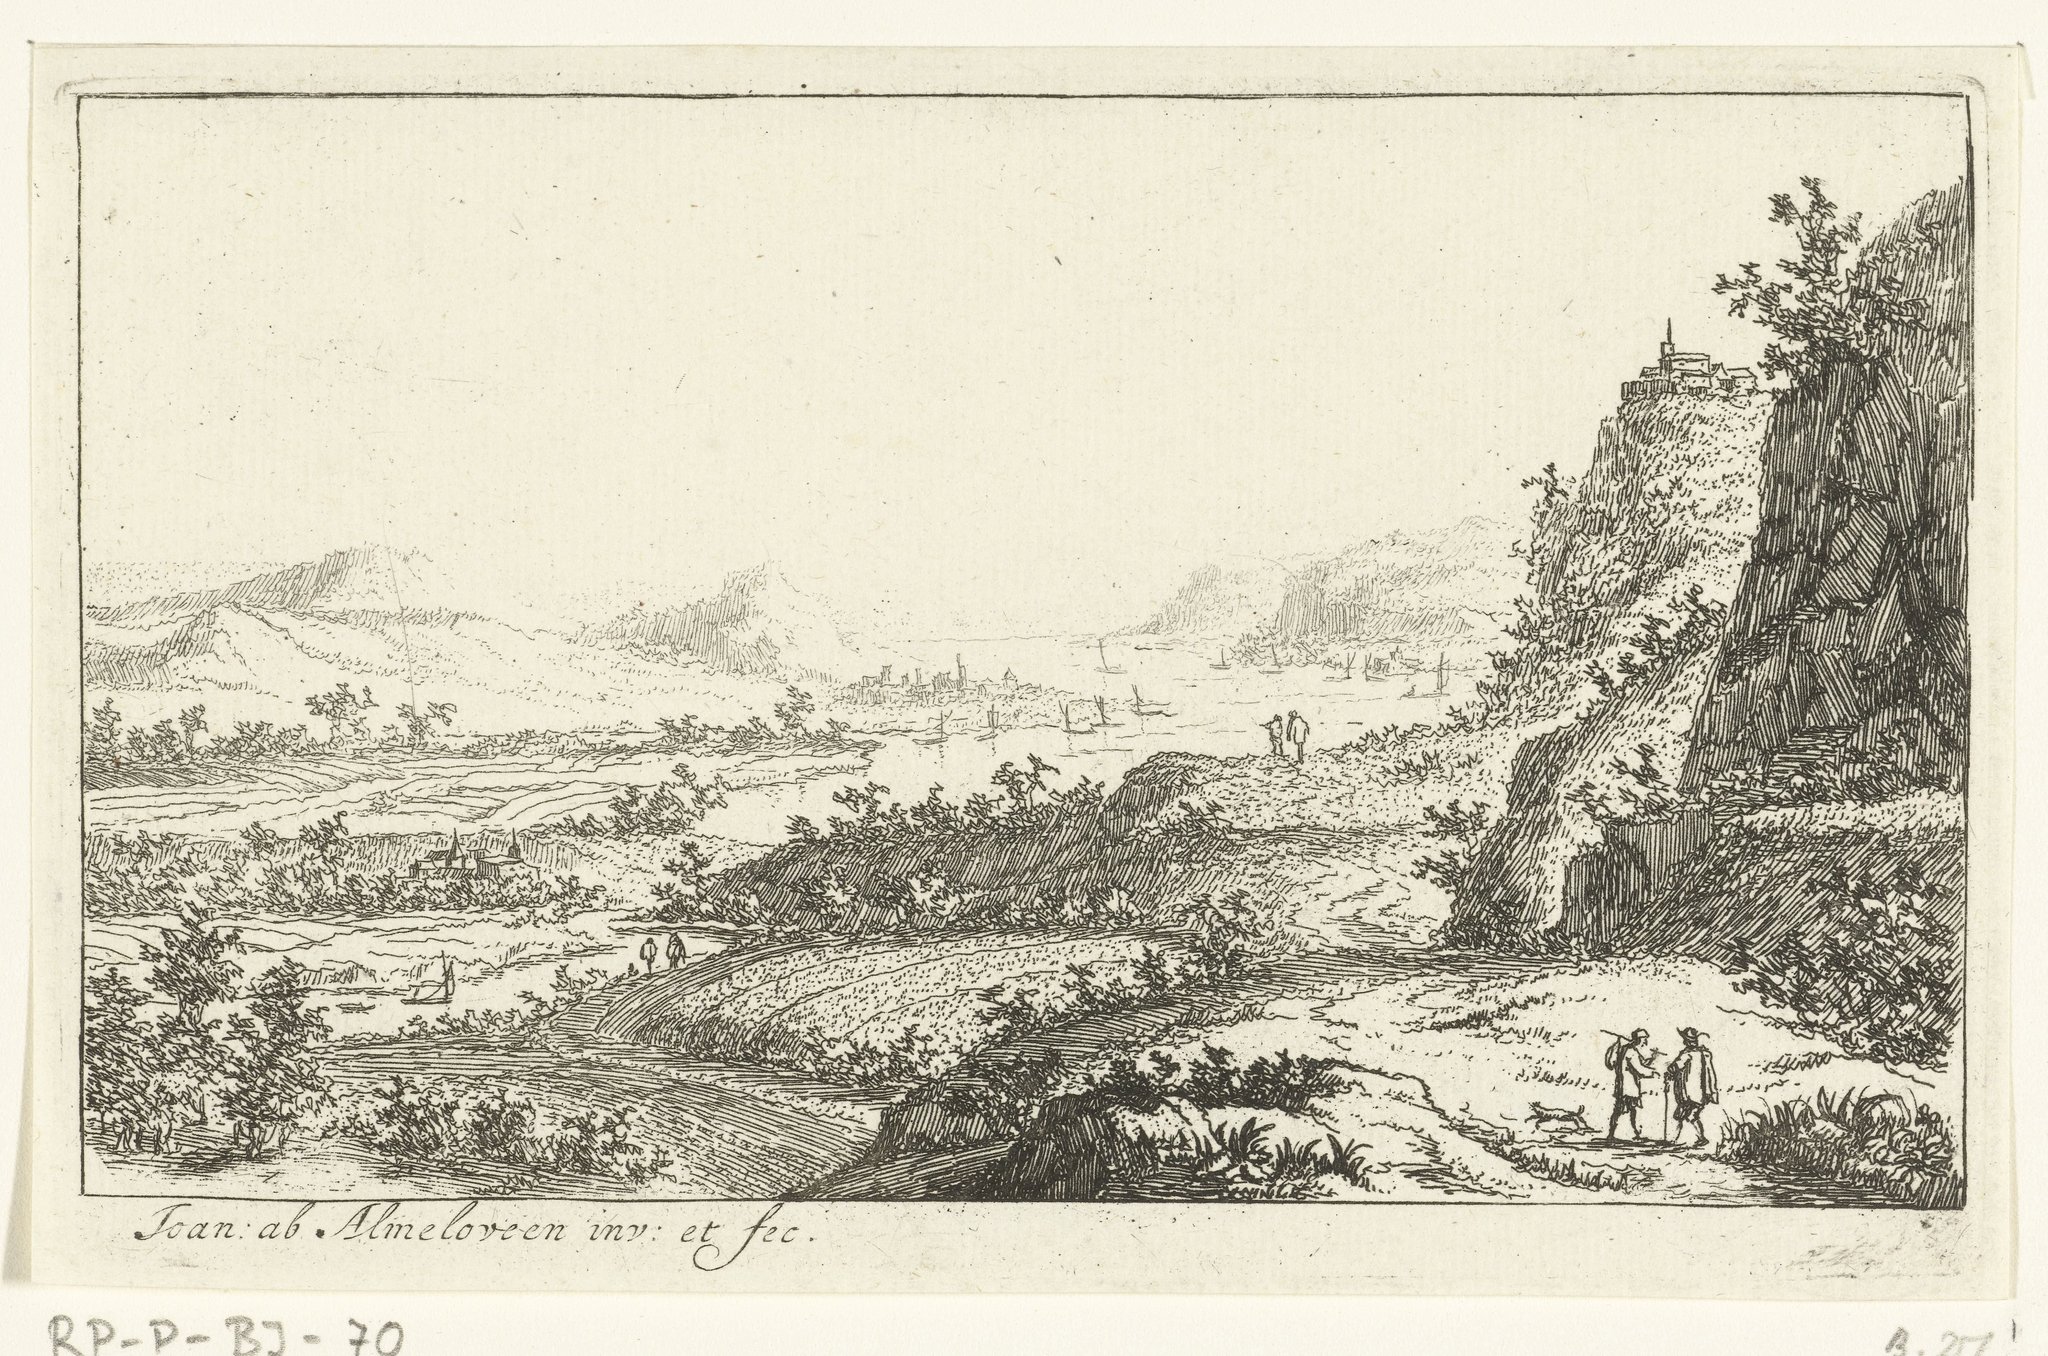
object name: print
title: Zes landschappen, tweede serie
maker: jan van almeloveen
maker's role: draughtsman, print maker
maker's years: 1652-1683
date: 1662-1683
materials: paper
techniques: etching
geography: netherlands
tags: river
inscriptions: collector's mark: Lugt 240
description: Prent uit een serie van zes rivierlandschappen. De rivier is mogelijk de Oder.